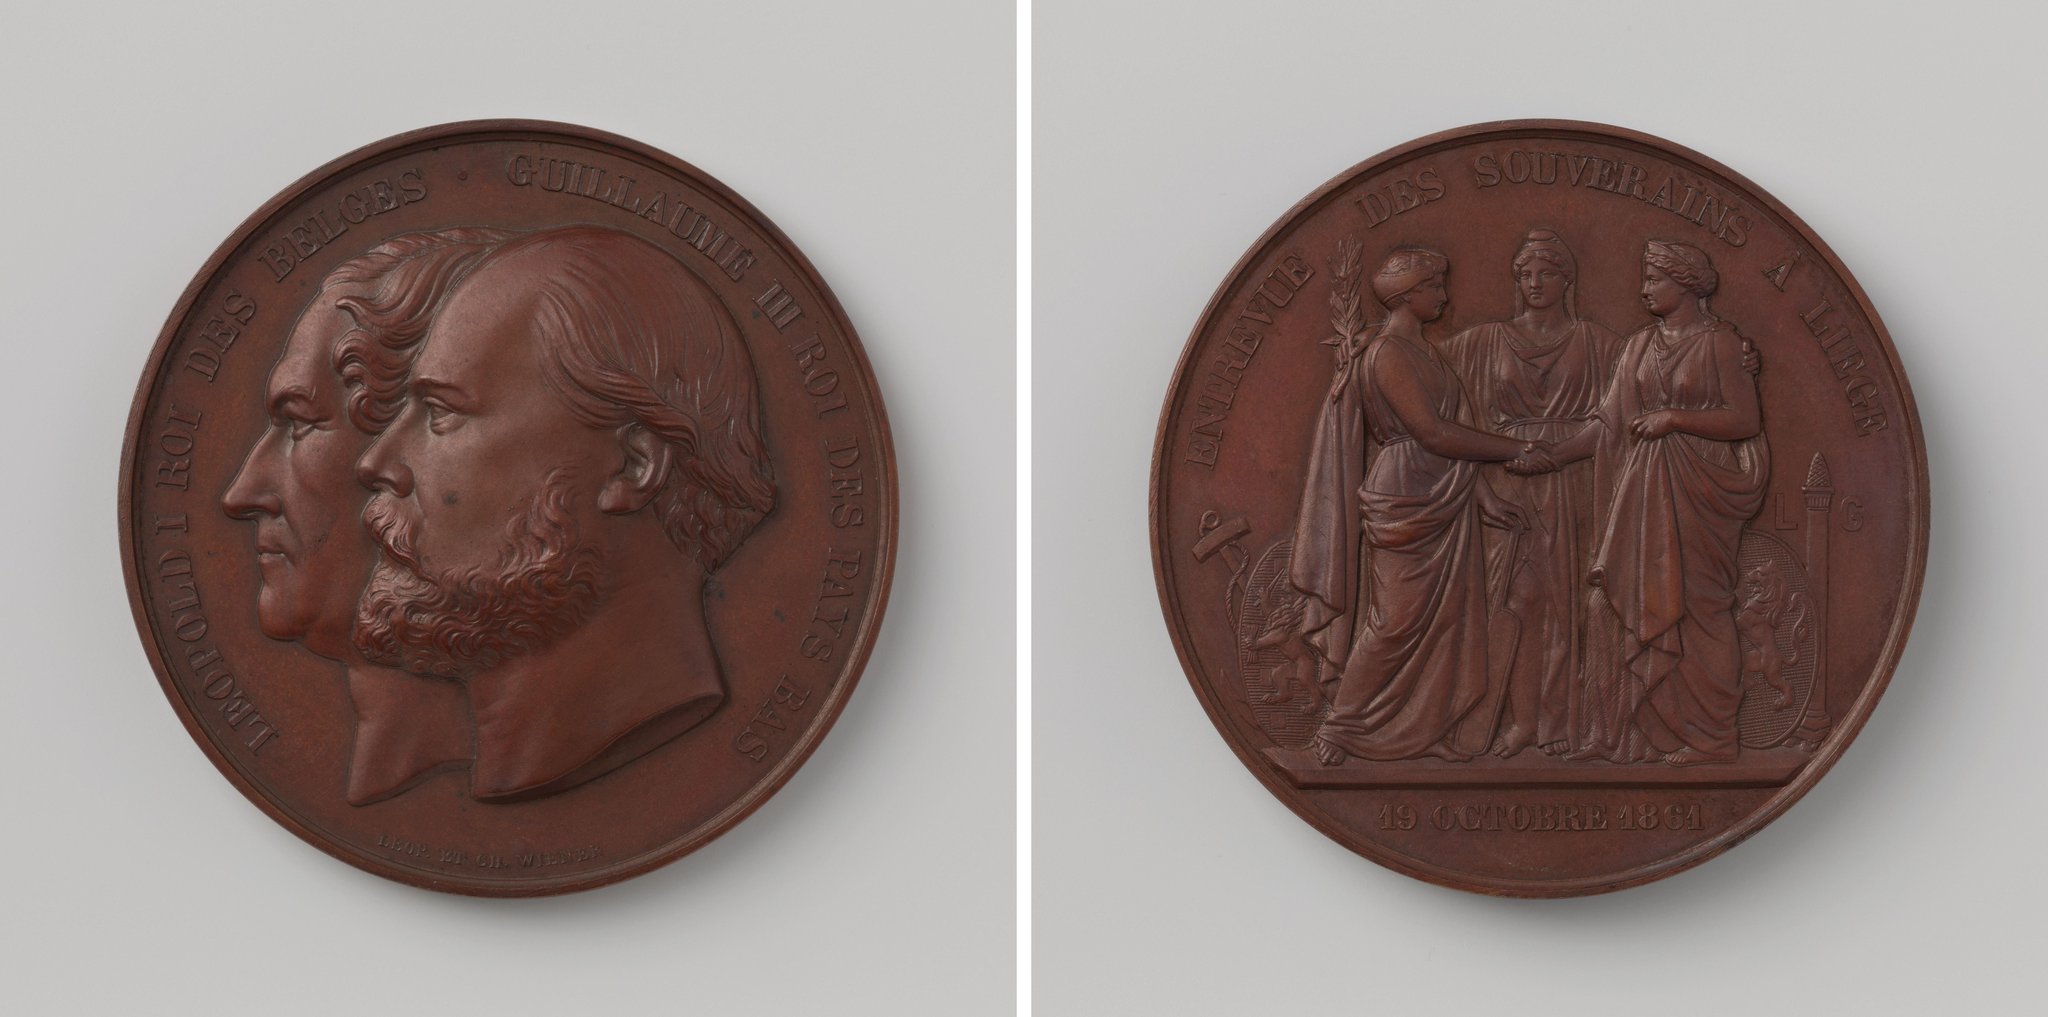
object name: history medal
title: Ontmoeting van Leopold I, koning der Belgen en Willem III, koning der Nederlanden te Luik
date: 1861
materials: bronze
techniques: striking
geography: brussels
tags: willem iii (koning der nederlanden), laeken, leopold i (koning der belgen), liège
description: Bronzen penning. Voorzijde: borststukken van twee mannen binnen omschrift. Keerzijde: Vrede, afgebeeld als vrouw met Phrygische muts op hoofd en olijftak in hand omhelst twee vrouwen, die elkaar hand schudden, voorstellende Nederland met linkerhand op scheepsroer en wapenschild tegen anker, en Belgie met wapenschild leunend tegen zuil binnen omschrift; afsnede: datering